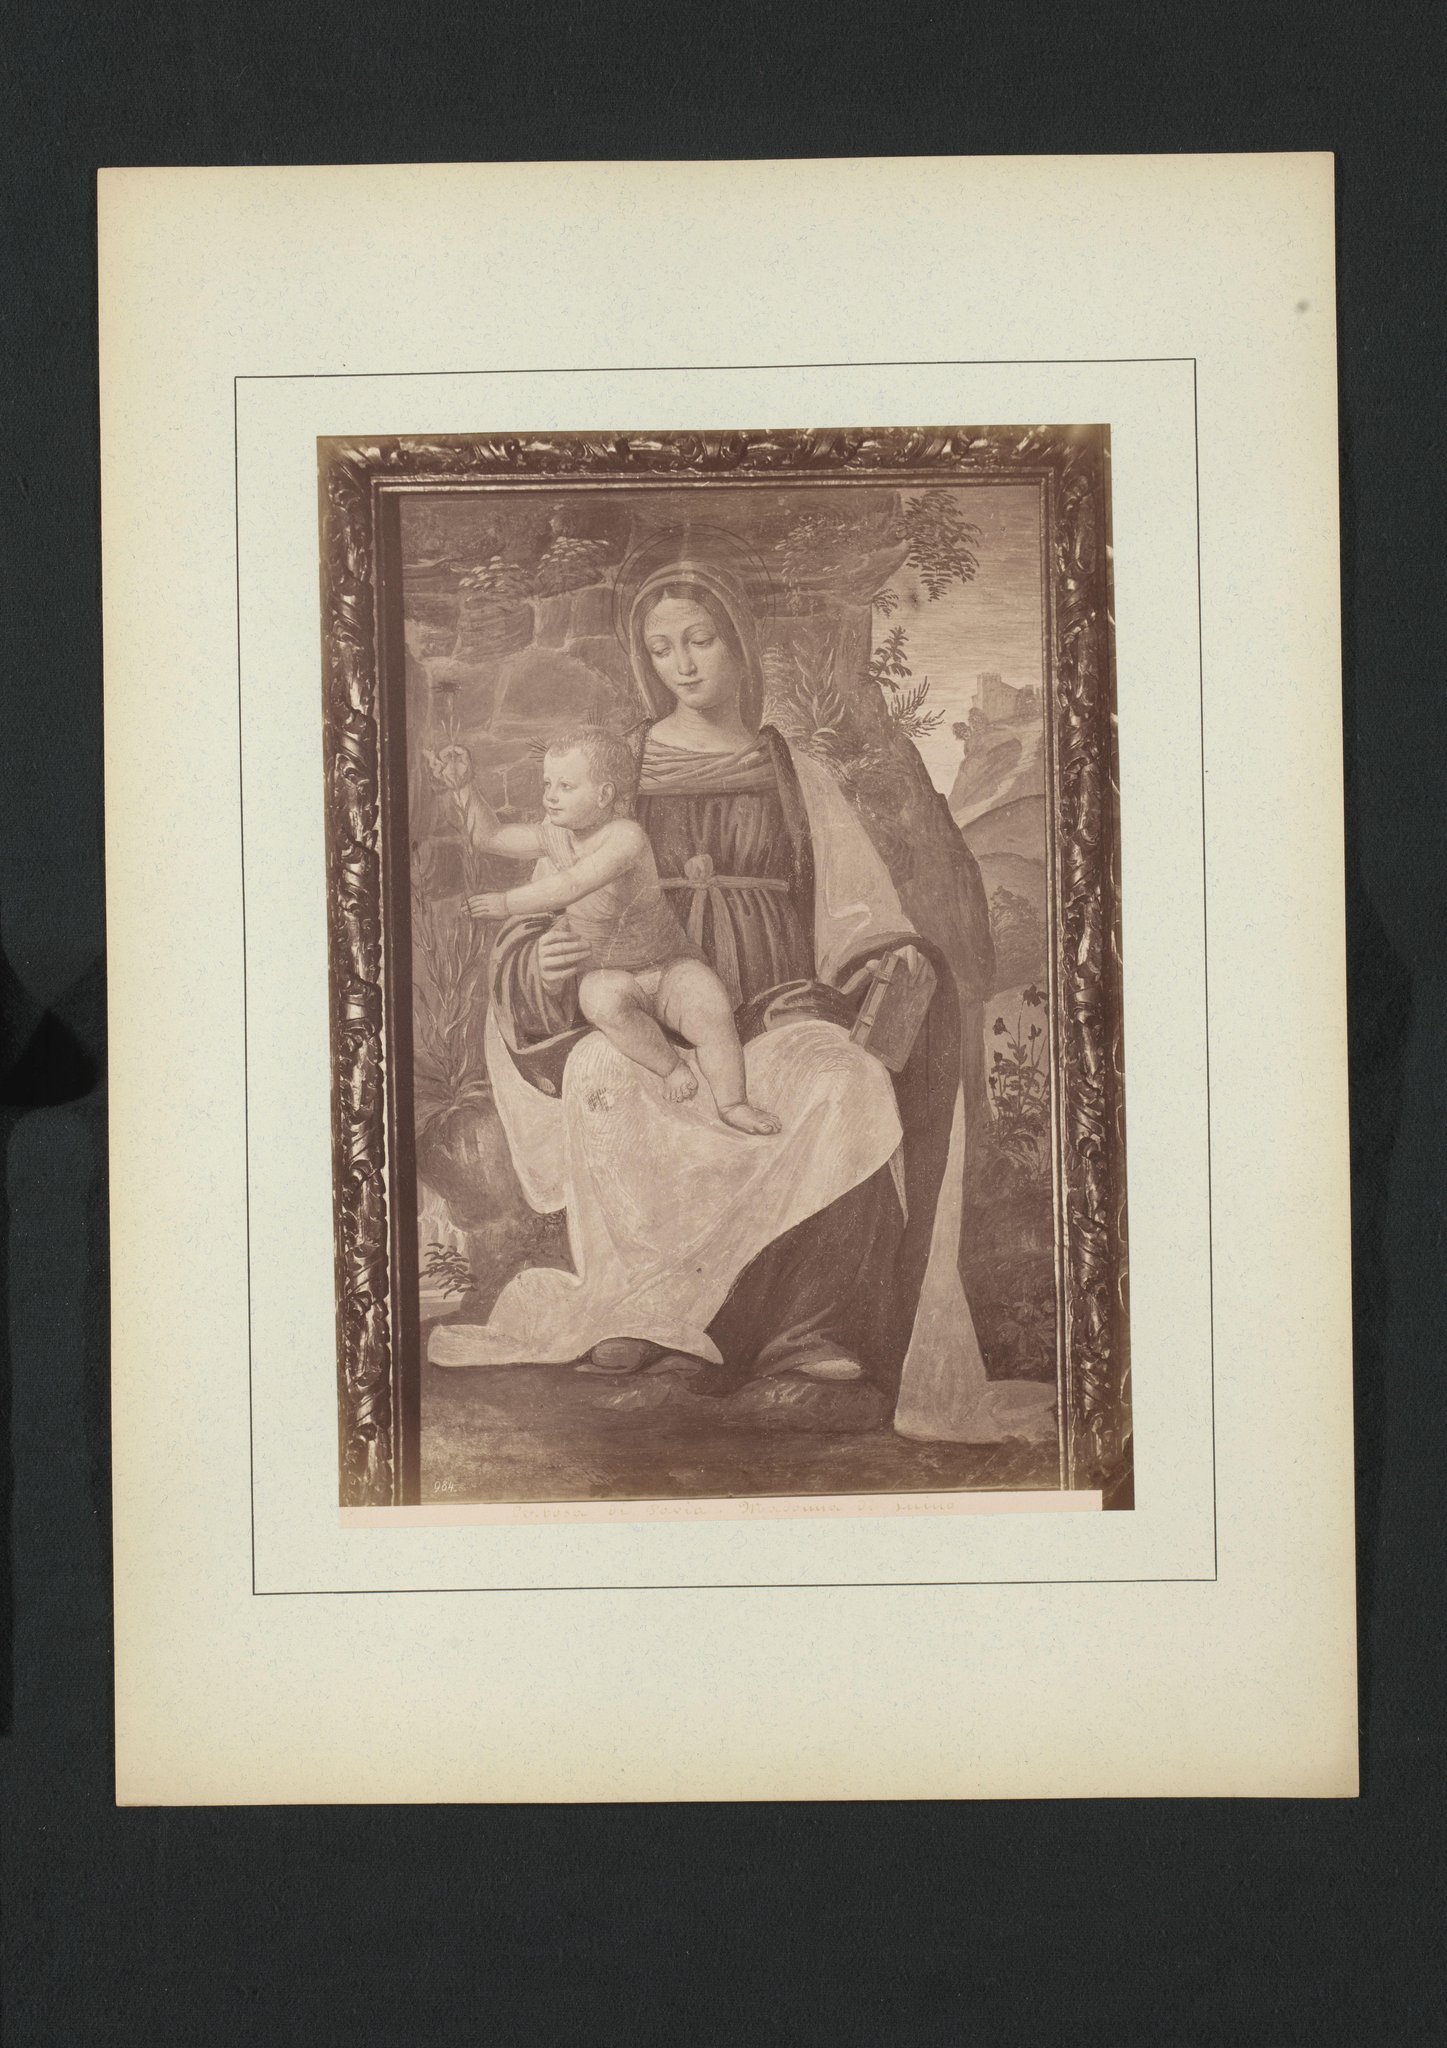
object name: photograph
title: Fotoreproductie van het fresco Madonna del Garofano door Bernardino Luini in de Certosa di Pavia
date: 1877-1882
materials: cardboard, photographic support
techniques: albumen print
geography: certosa di pavia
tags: madonna: i.e. mary with the christ-child, painting (including book-illumination, miniature-painting) (+ mural painting)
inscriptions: number: ‘984’, inscription: ‘No. 10. Madonna von Luini in der Sacristei.’